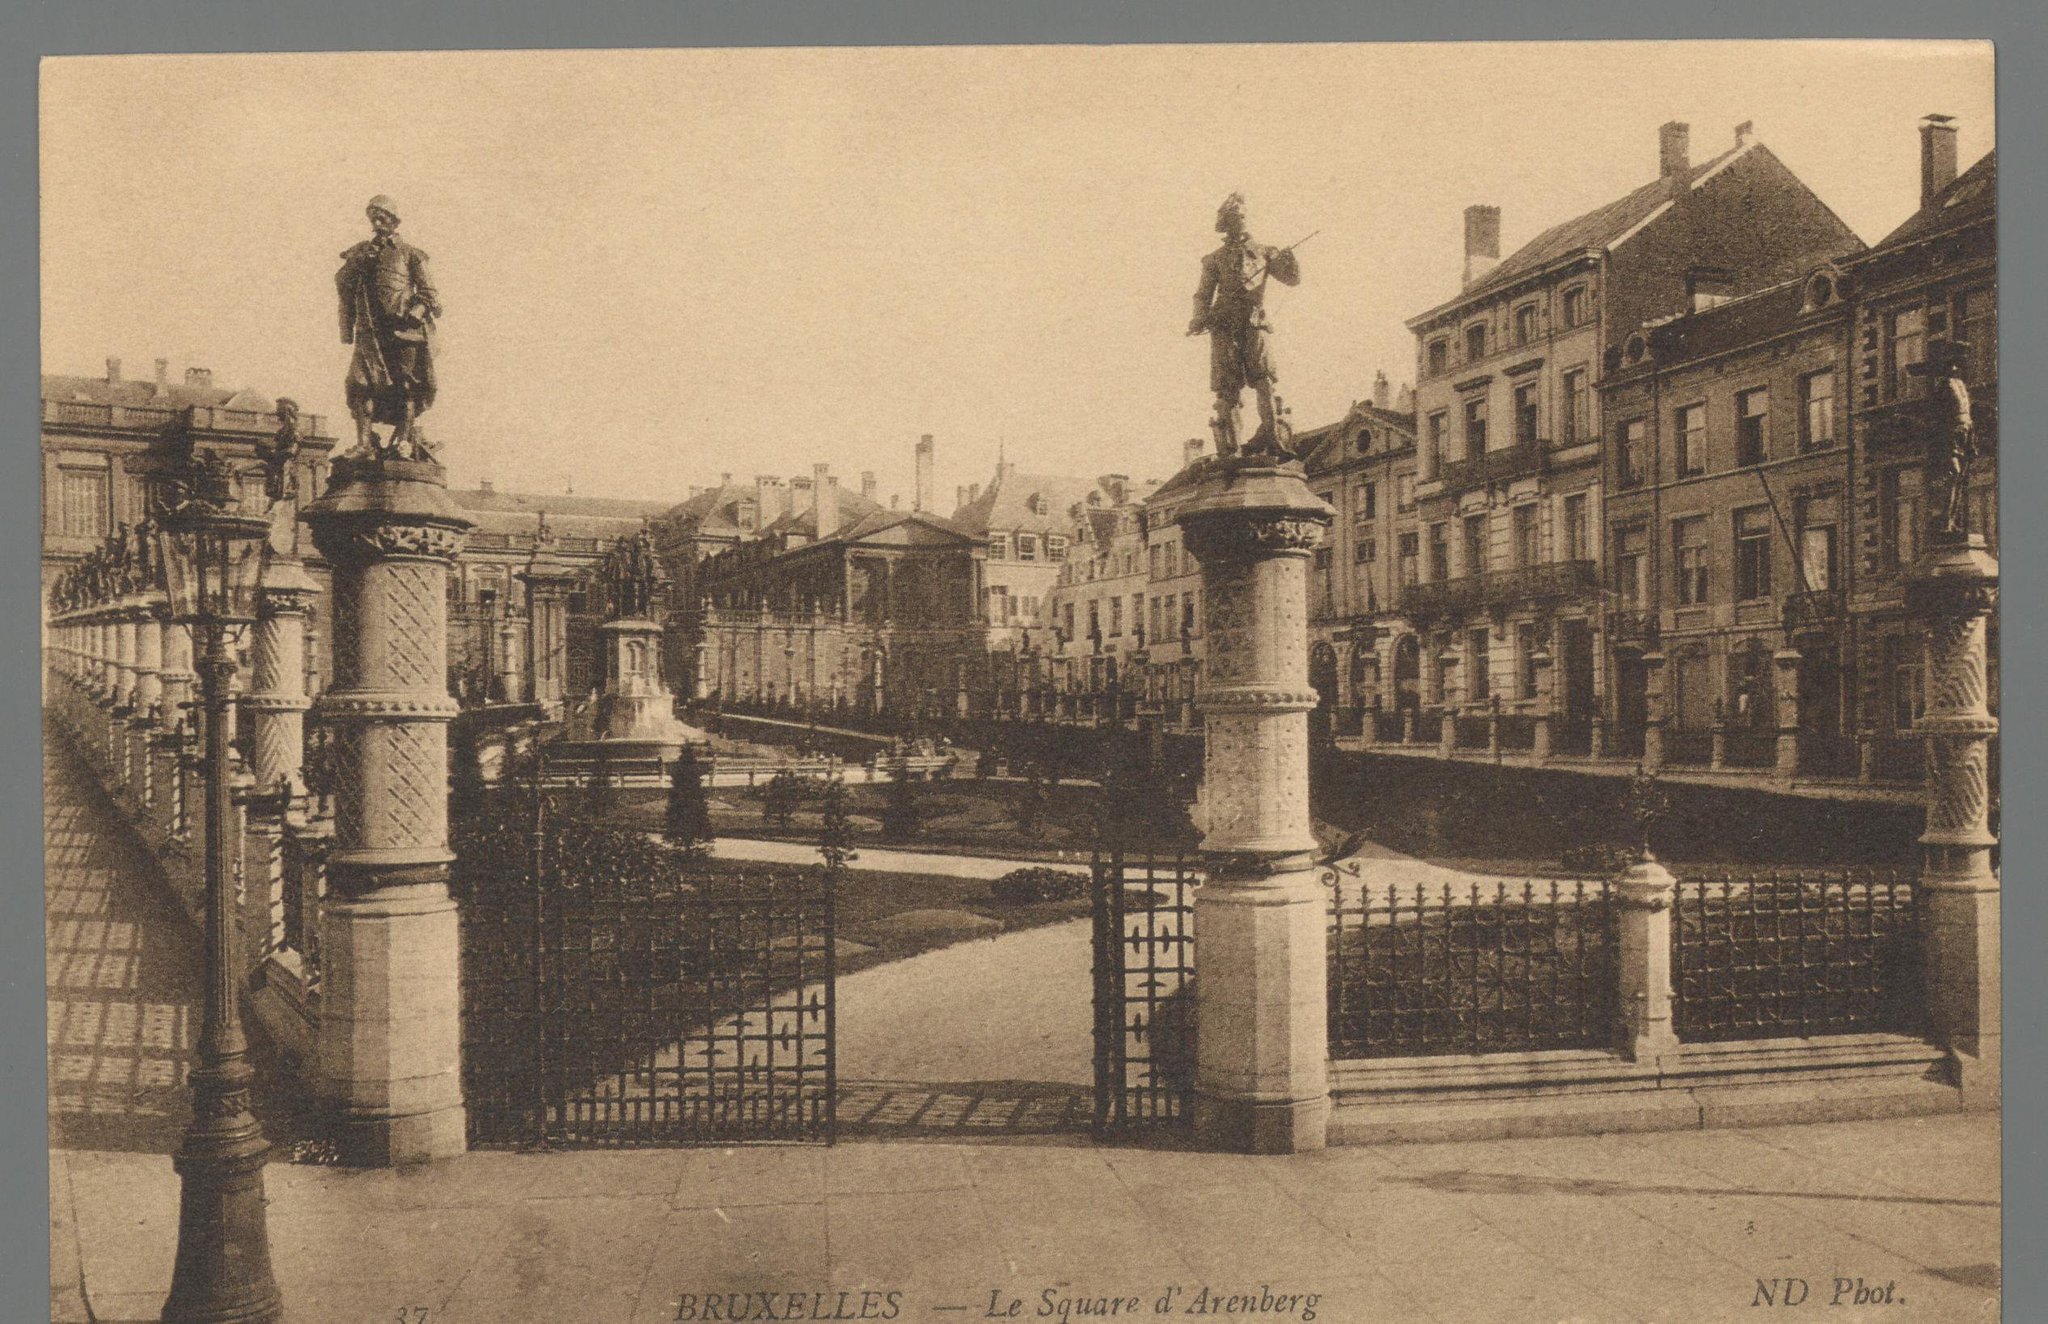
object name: photomechanical print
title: Bruxelles. Le Square d'Arenberg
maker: Anonymous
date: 1906-1918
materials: cardboard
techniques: photograph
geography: brussels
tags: park, monument, statue, brussels